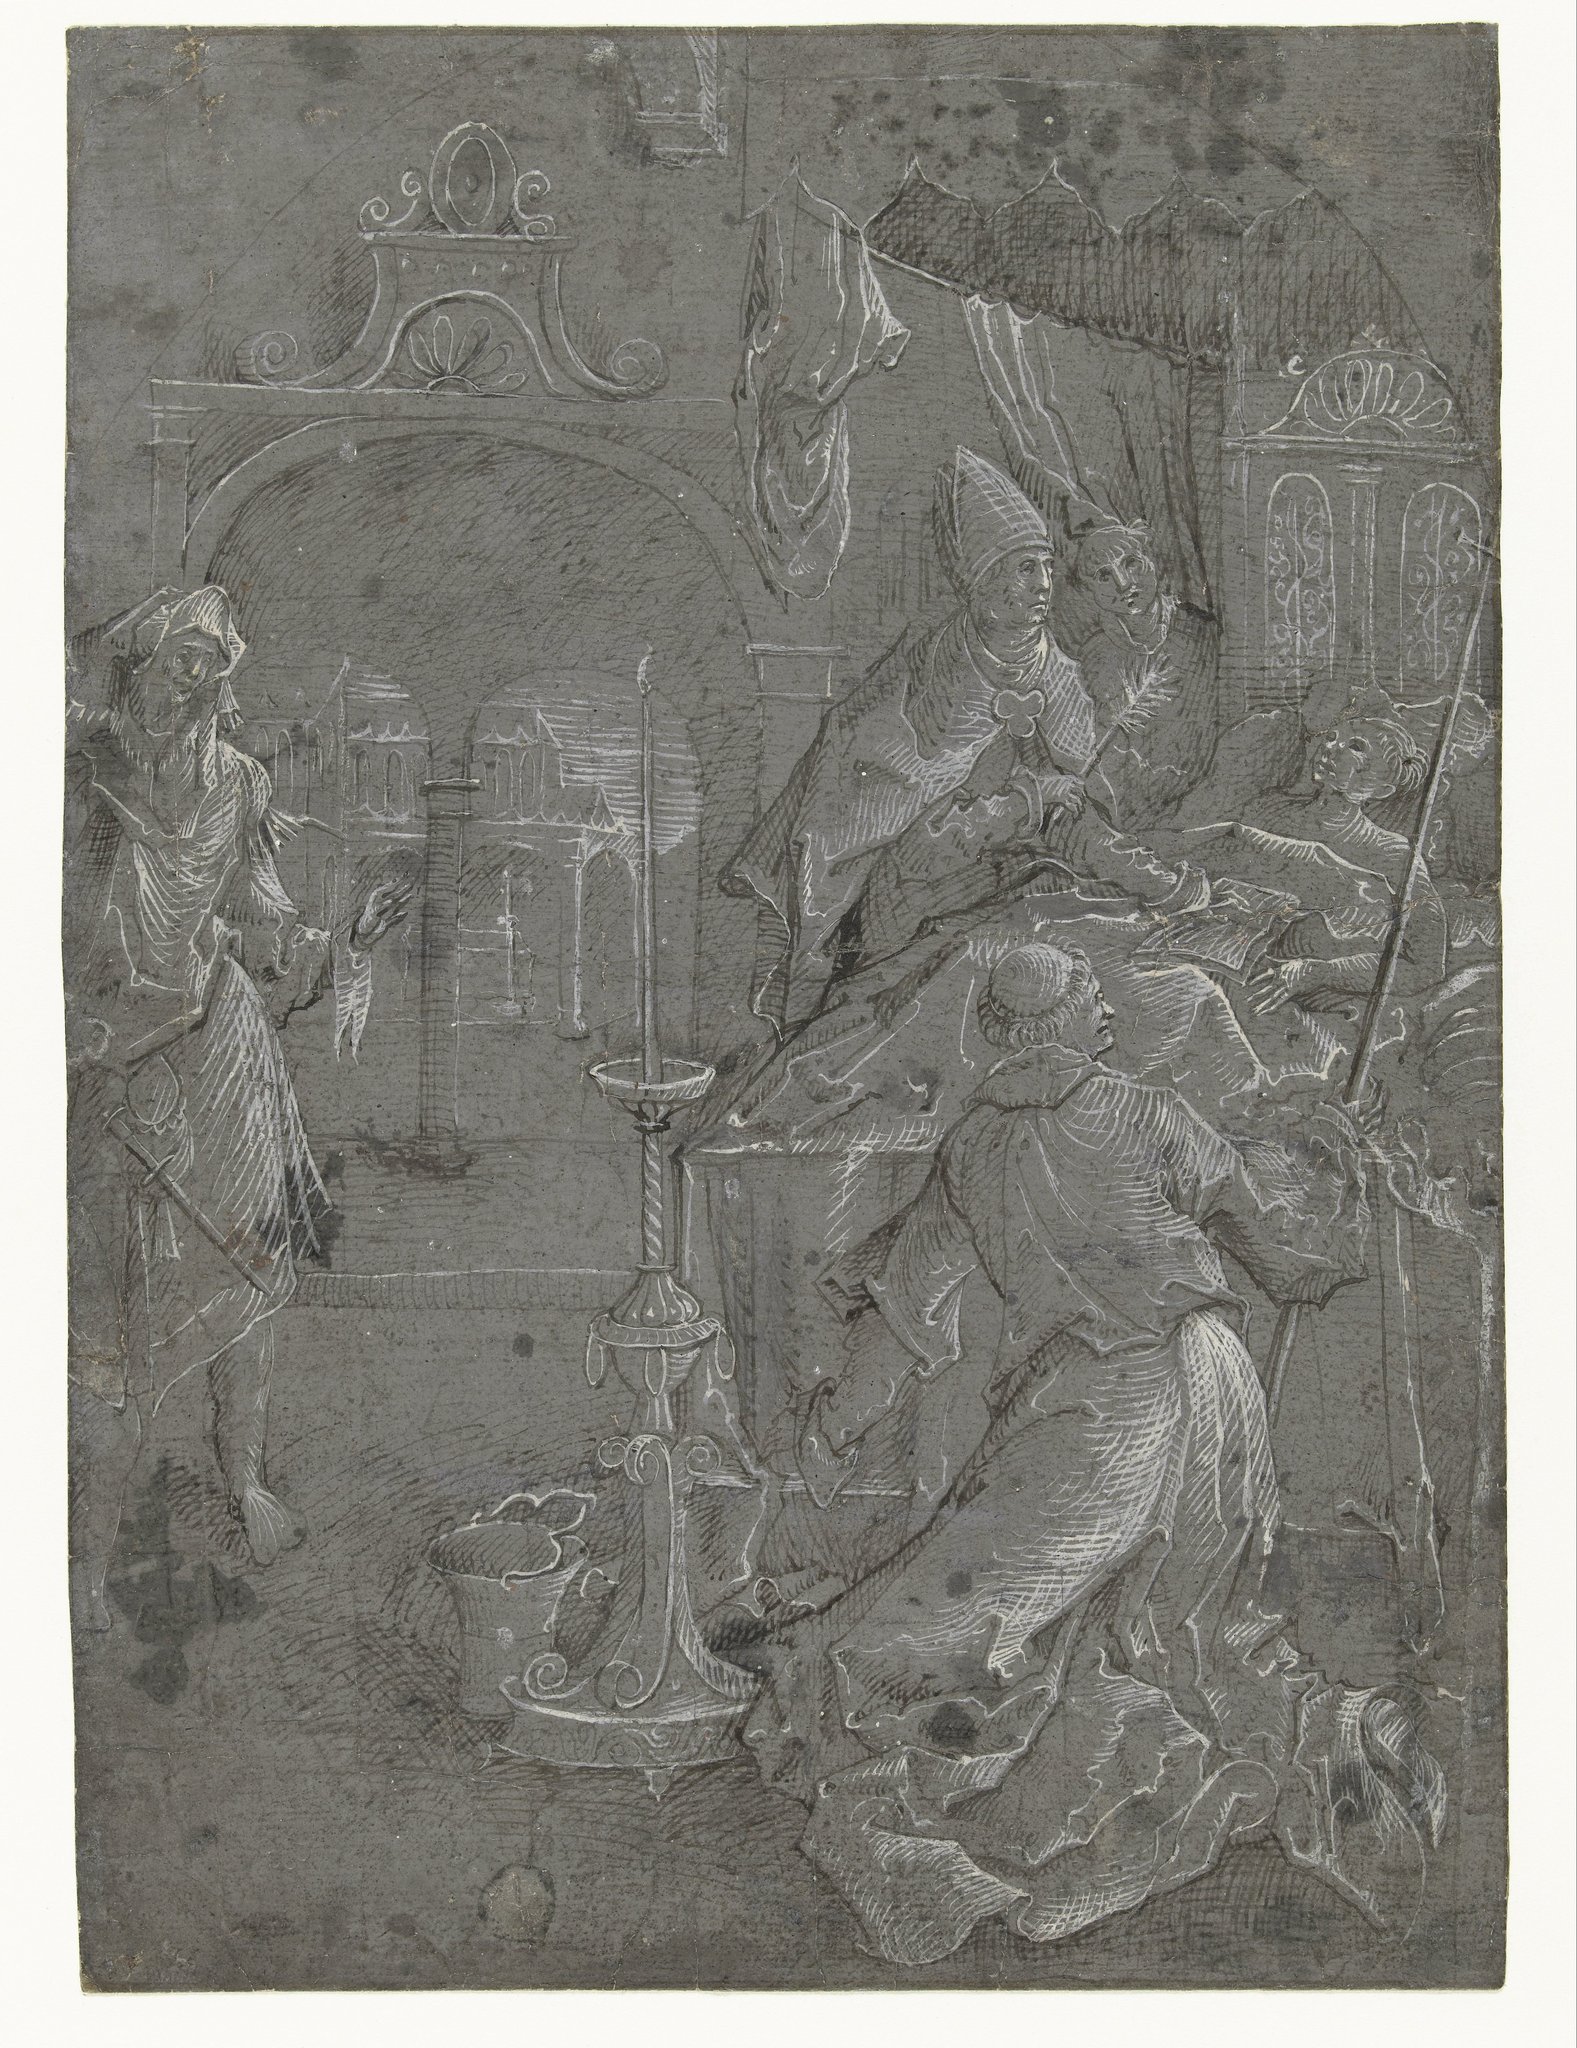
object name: design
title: Het Sacrament der stervenden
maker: Anonymous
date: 1510-1530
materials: ink, paper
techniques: brush, pen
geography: antwerp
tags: deathbed, priest at the bed of a dying person ~ extreme unction